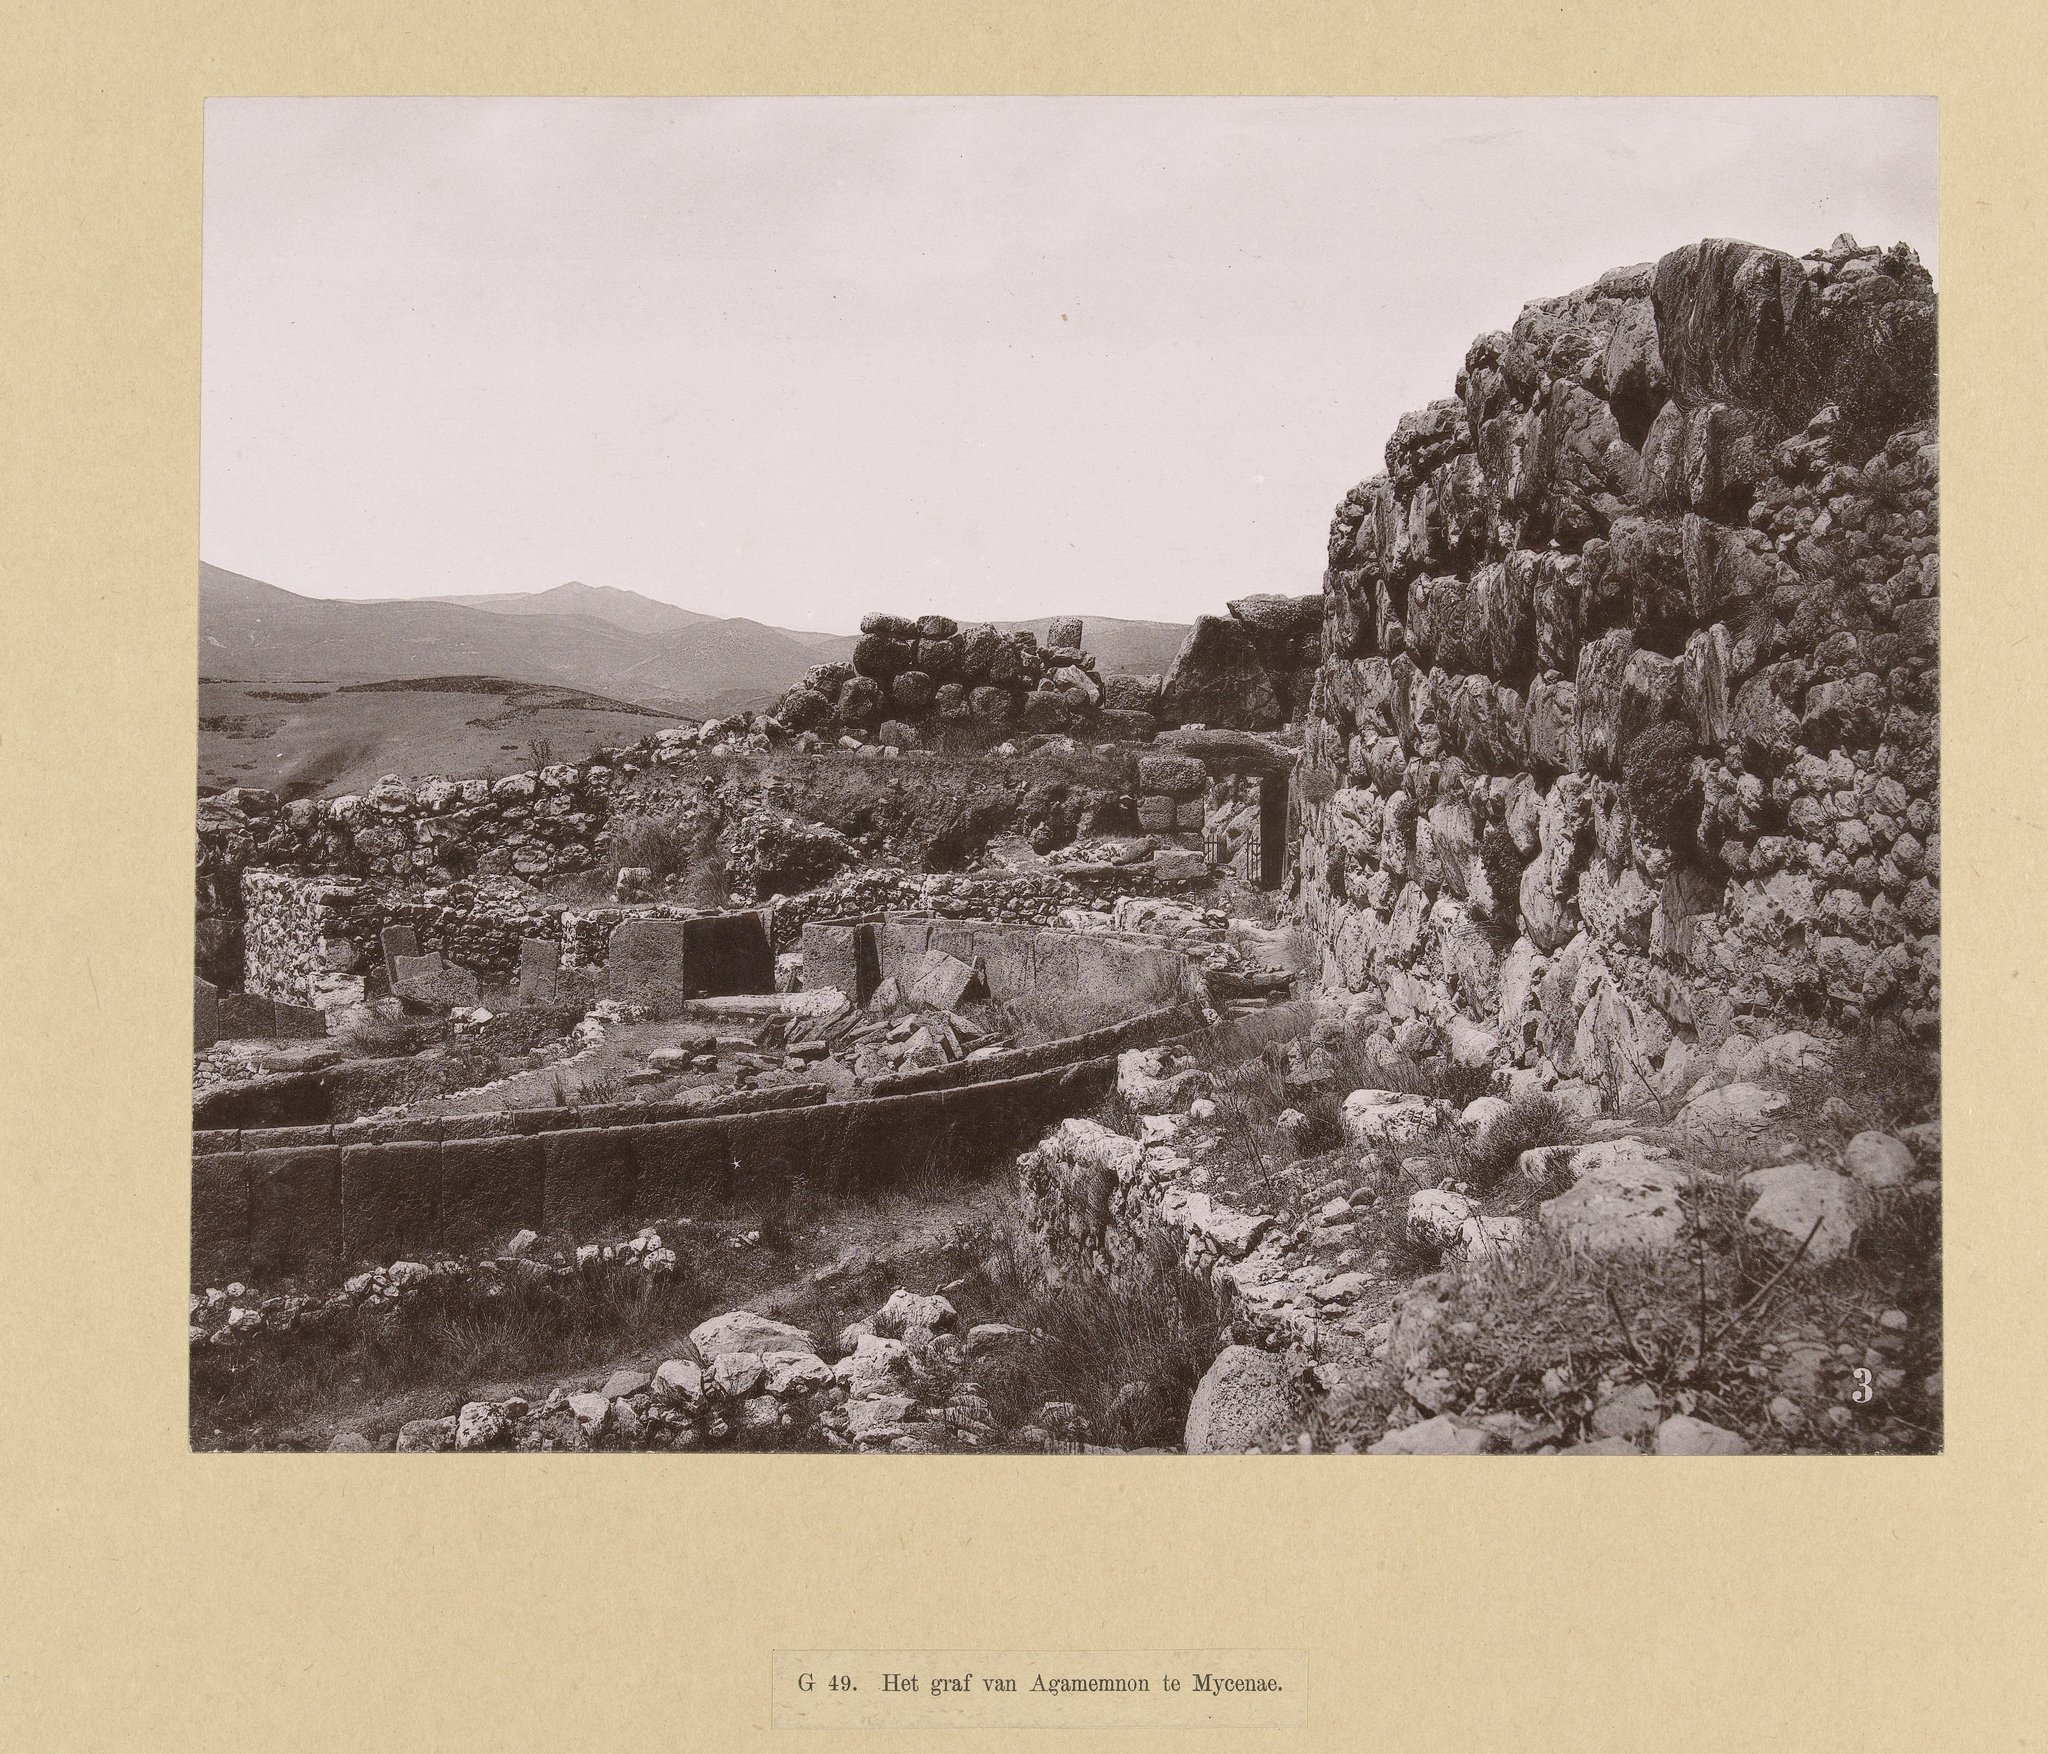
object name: photomechanical print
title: Grafcirkel in Mycene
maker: Anonymous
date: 1890-1895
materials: cardboard, paper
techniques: photograph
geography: mycene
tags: ancient grave forms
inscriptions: check stamp: ‘Bristol/ L.M.’, title: ‘G 49. Het graf van Agamemnon te Mycenae.’, number: ‘3’, stamp: ‘Gemeentelijke bibliotheek/ Rotterdam’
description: Onderdeel van een groep door fotograaf Richard Polak op reis verzamelde foto’s. Deze fotomechanische afdruk is samen met andere op zijn reizen verzamelde foto's tentoongesteld bij de Rotterdamsche Kunstkring (1895), Arti en Amicitiae te Amsterdam (1897-1898?) en Societeit 't Collegie te Kampen (datum vooralsnog onbekend).